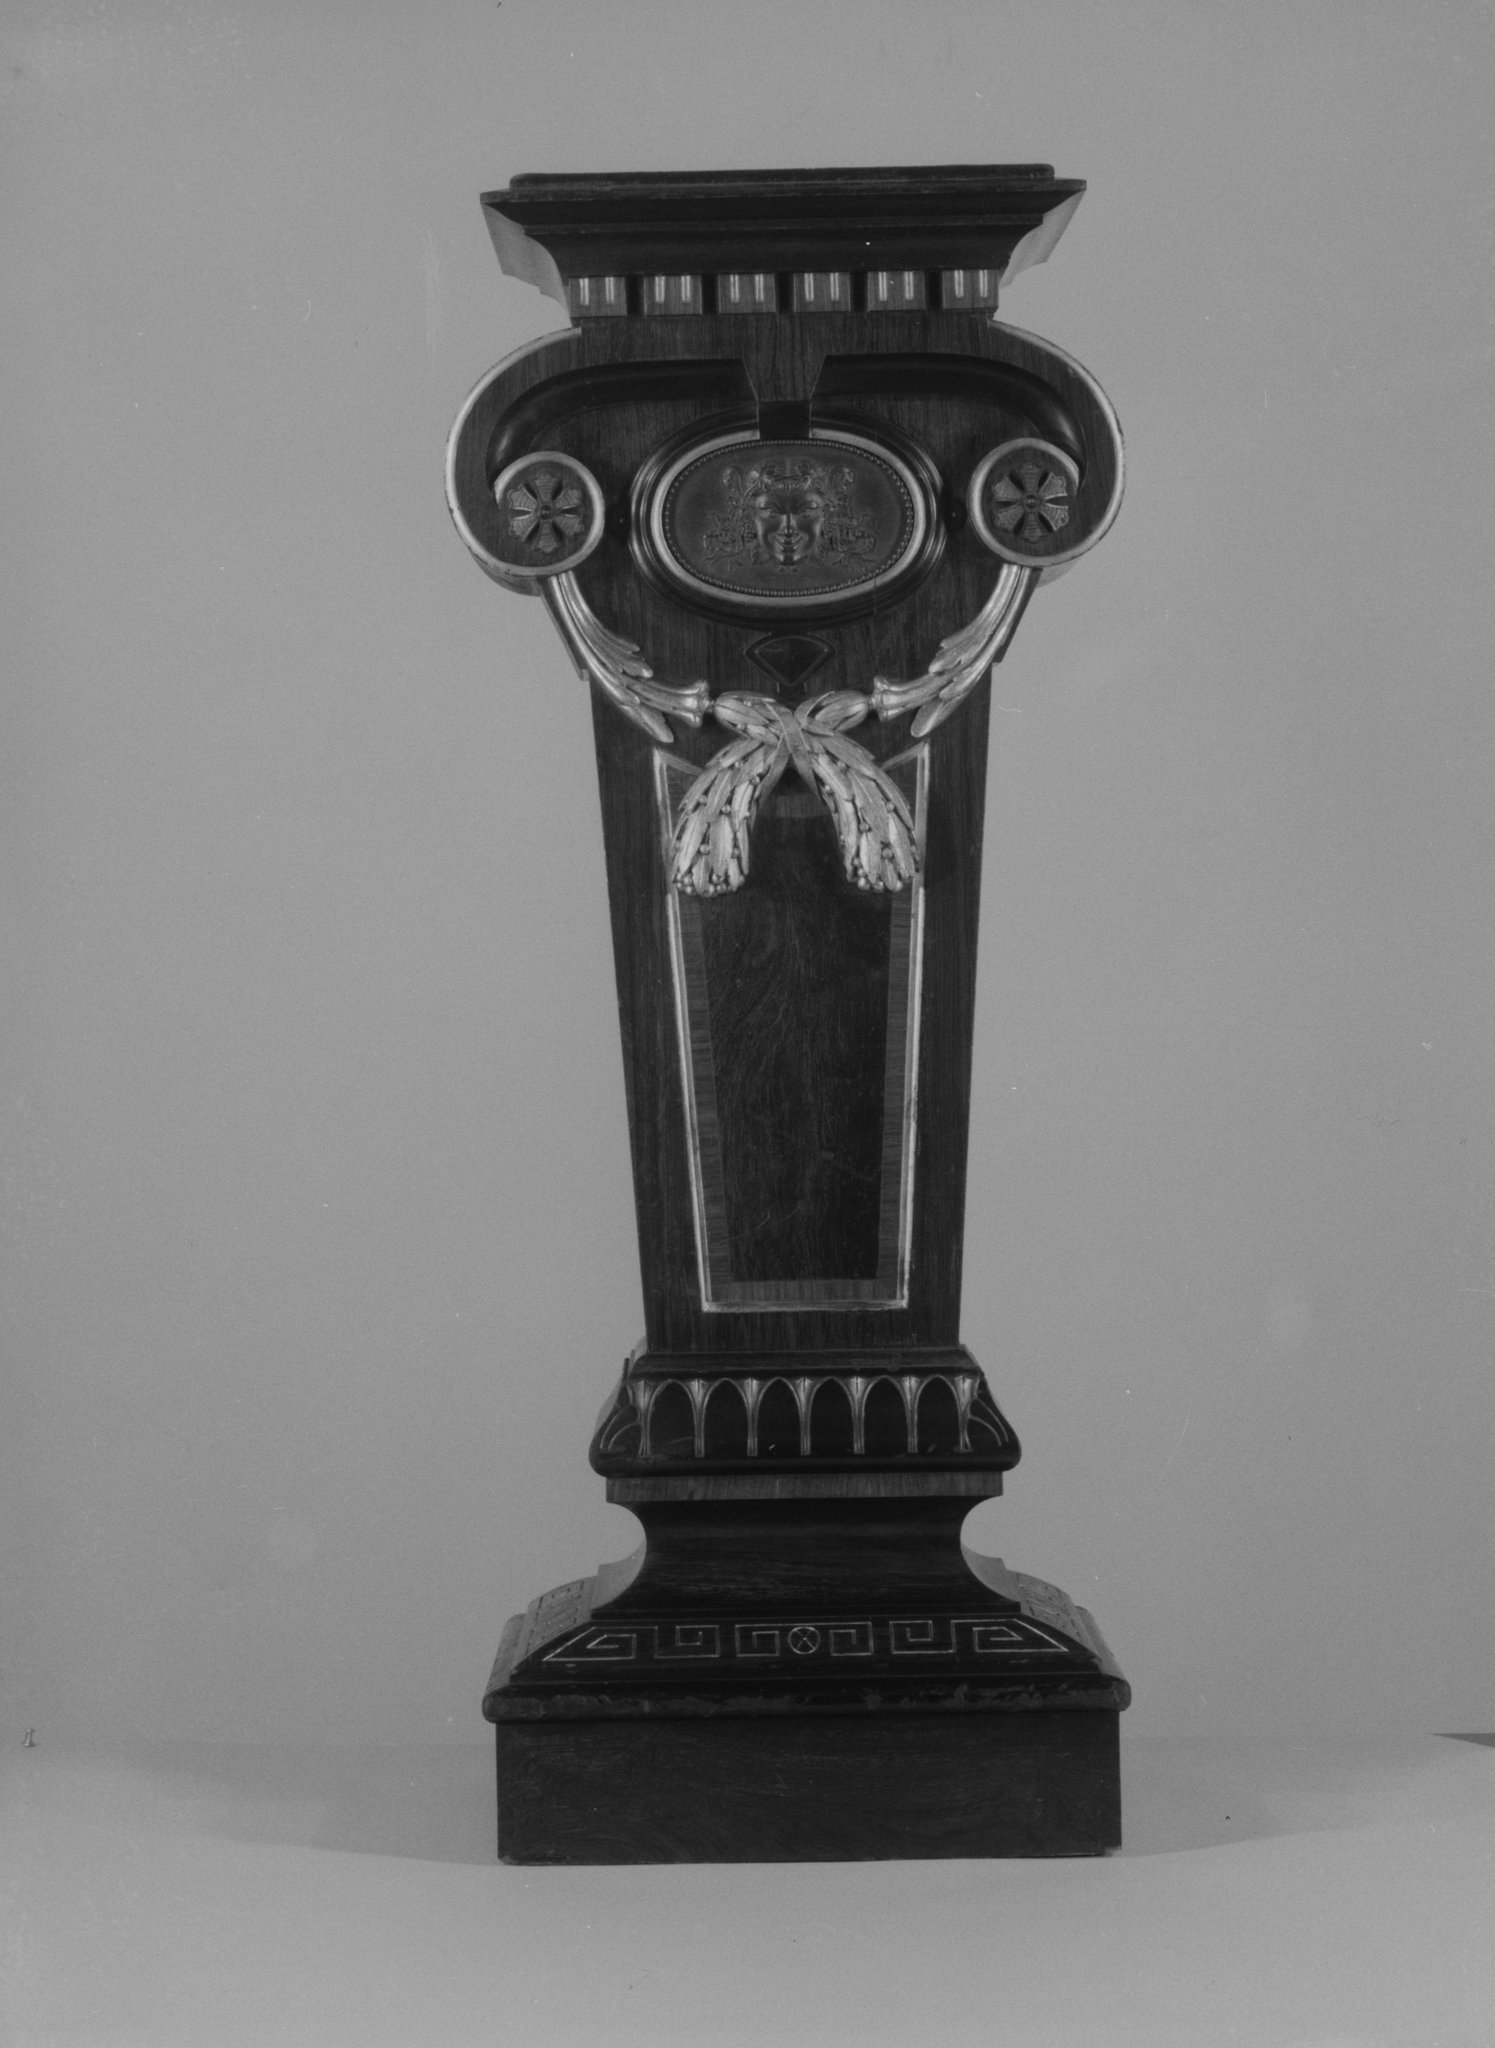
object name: pedestal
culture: american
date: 1870-1875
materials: wood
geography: united states